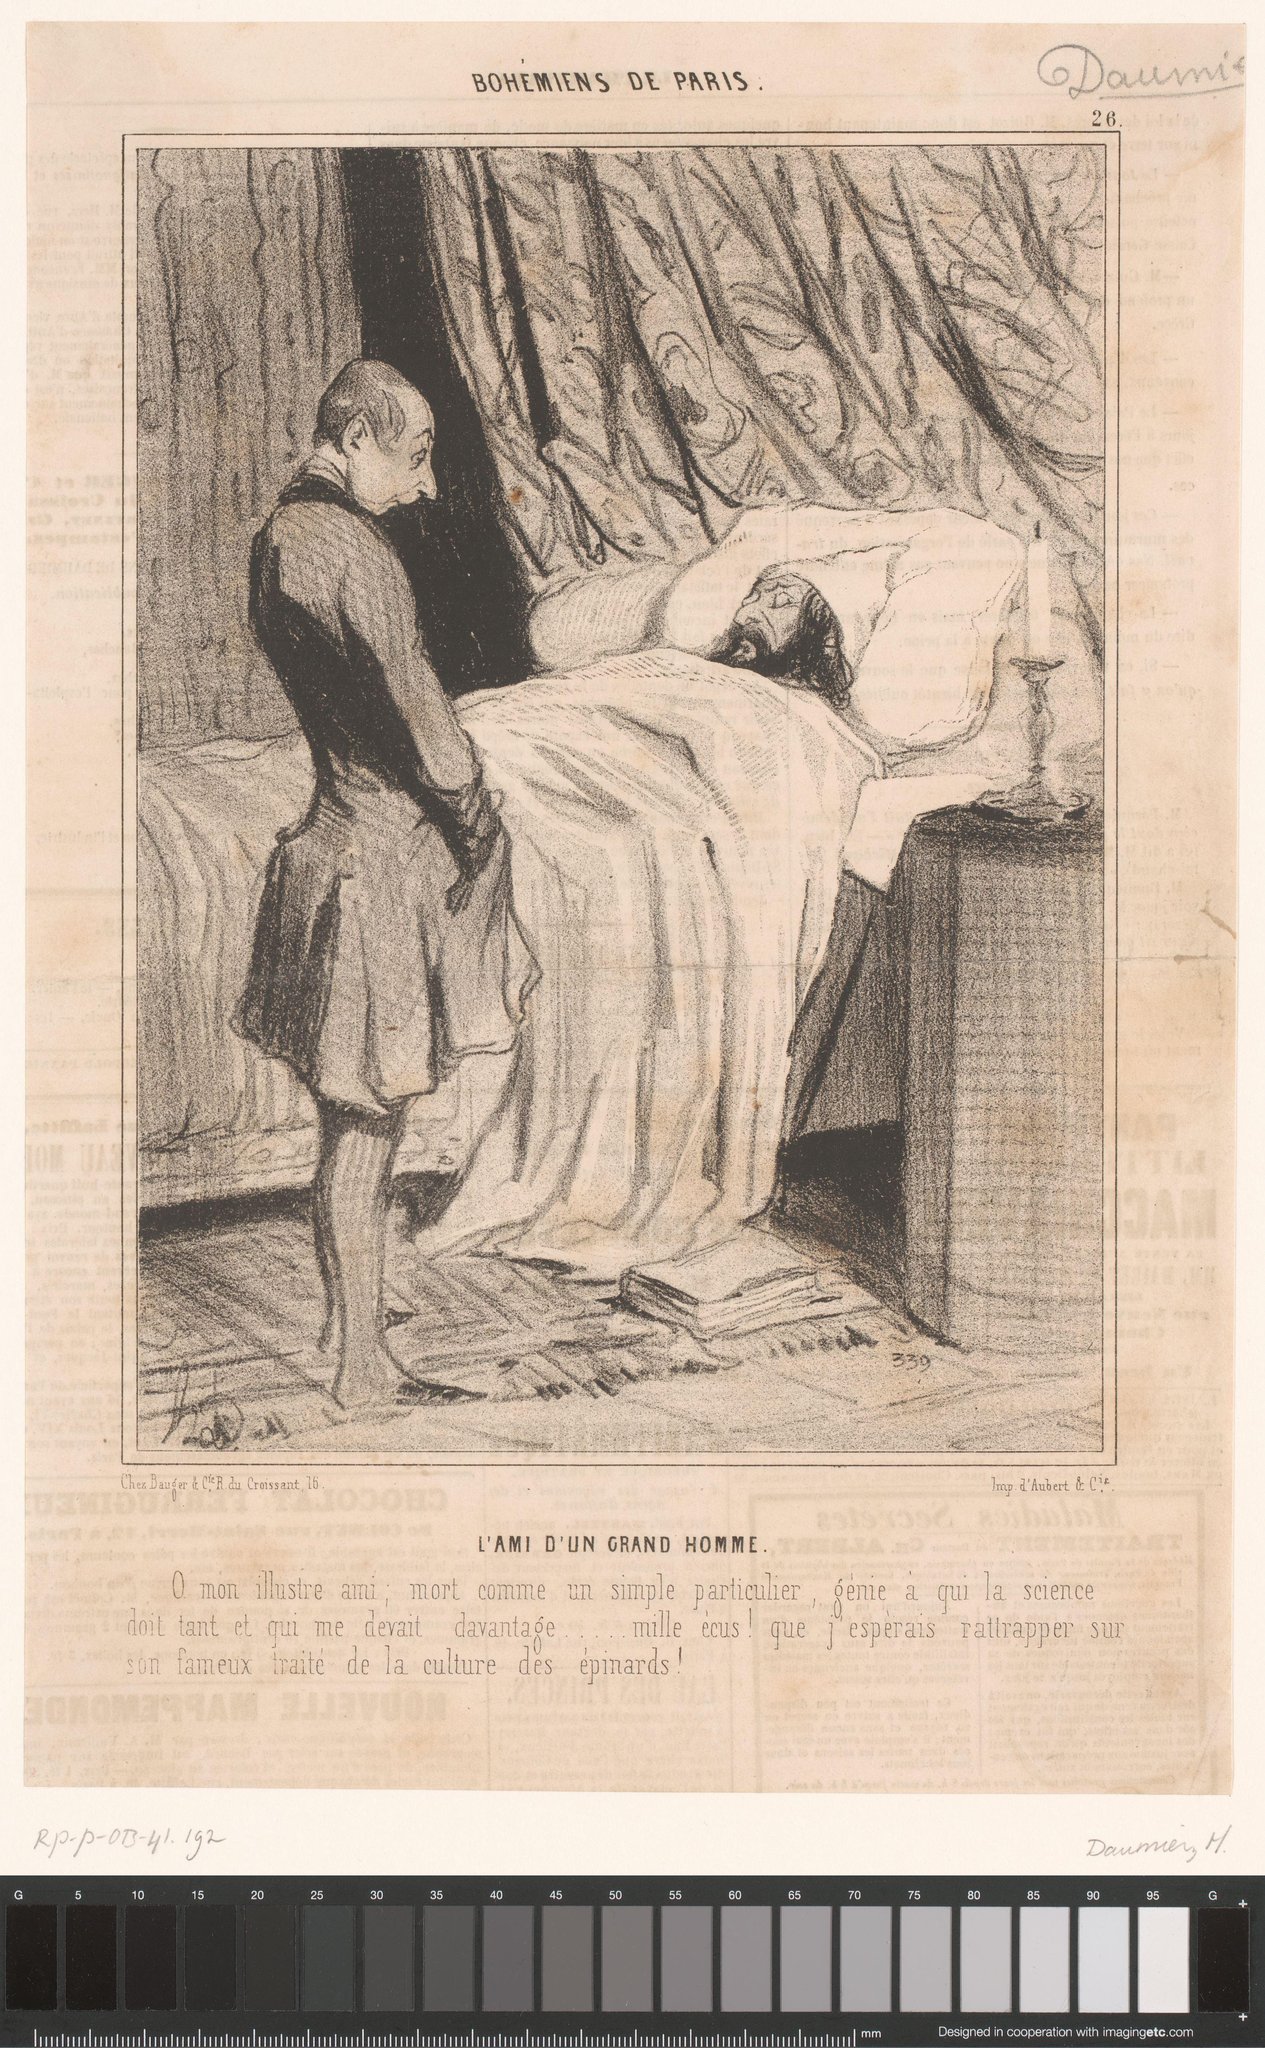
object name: cartoon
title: Parijse bohemiens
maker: honoré daumier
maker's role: draughtsman, painter, print maker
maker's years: 1808-1879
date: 1842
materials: paper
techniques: lithograph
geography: paris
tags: caricatures (human types), deathbed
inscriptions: collector's mark: Lugt 2228a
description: Prent gebruikt voor: Le Charivari, 20 maart 1842.